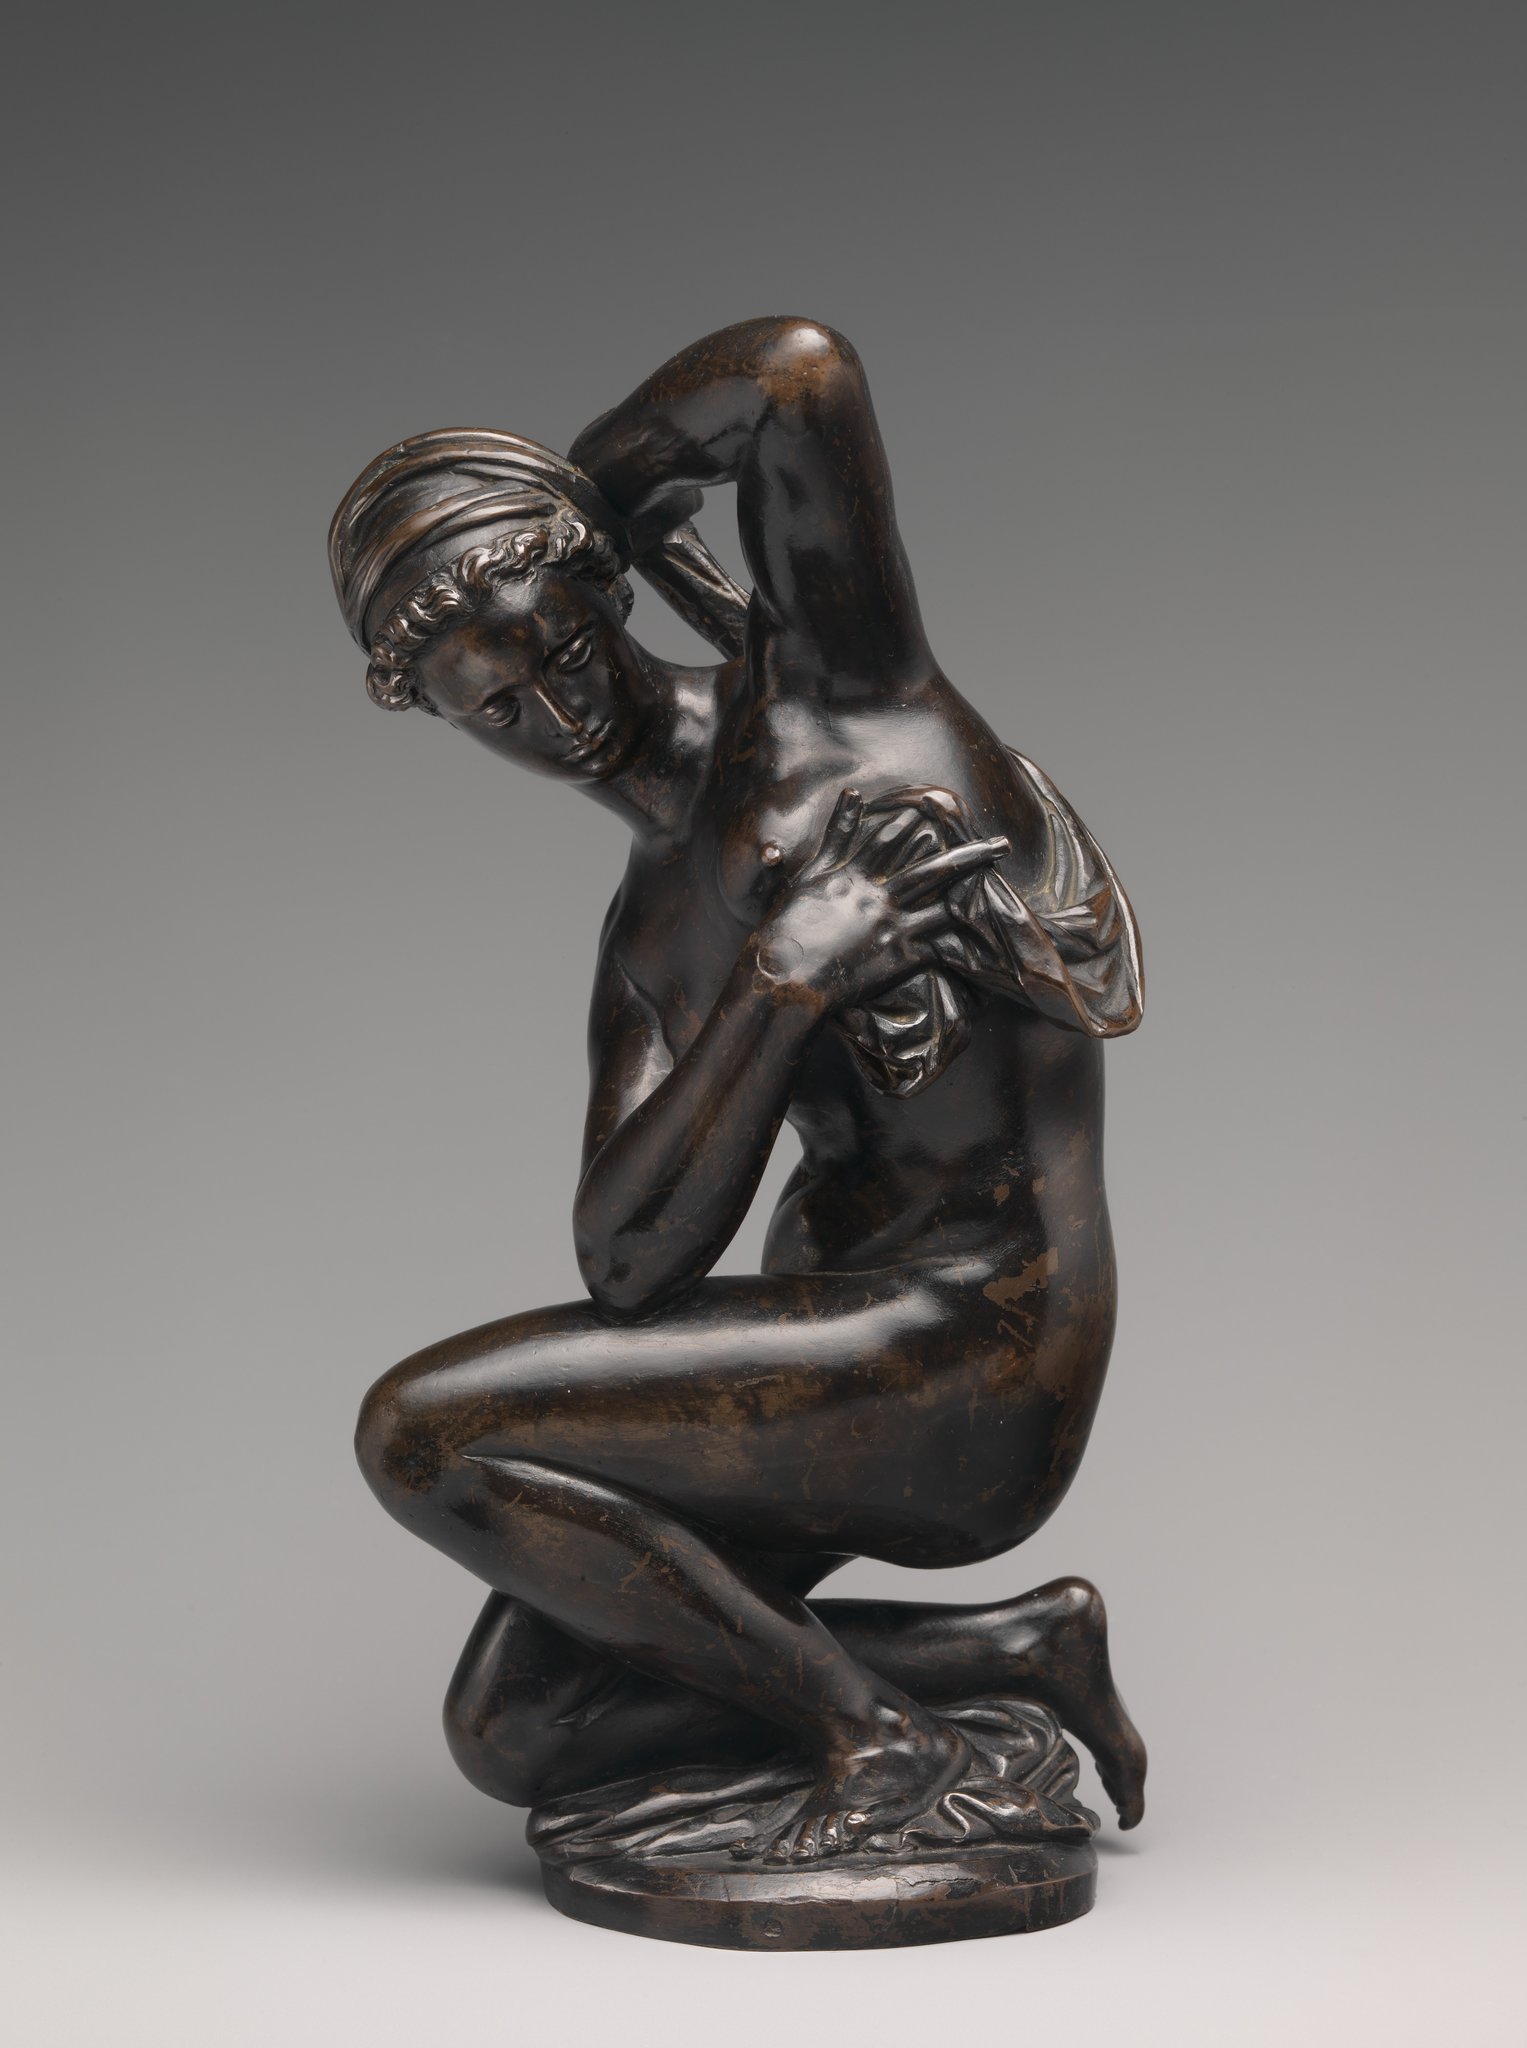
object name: statuette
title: Crouching Venus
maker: giambologna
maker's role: artist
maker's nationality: netherlandish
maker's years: 1529-1608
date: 1601-1700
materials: bronze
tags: female nudes,venus